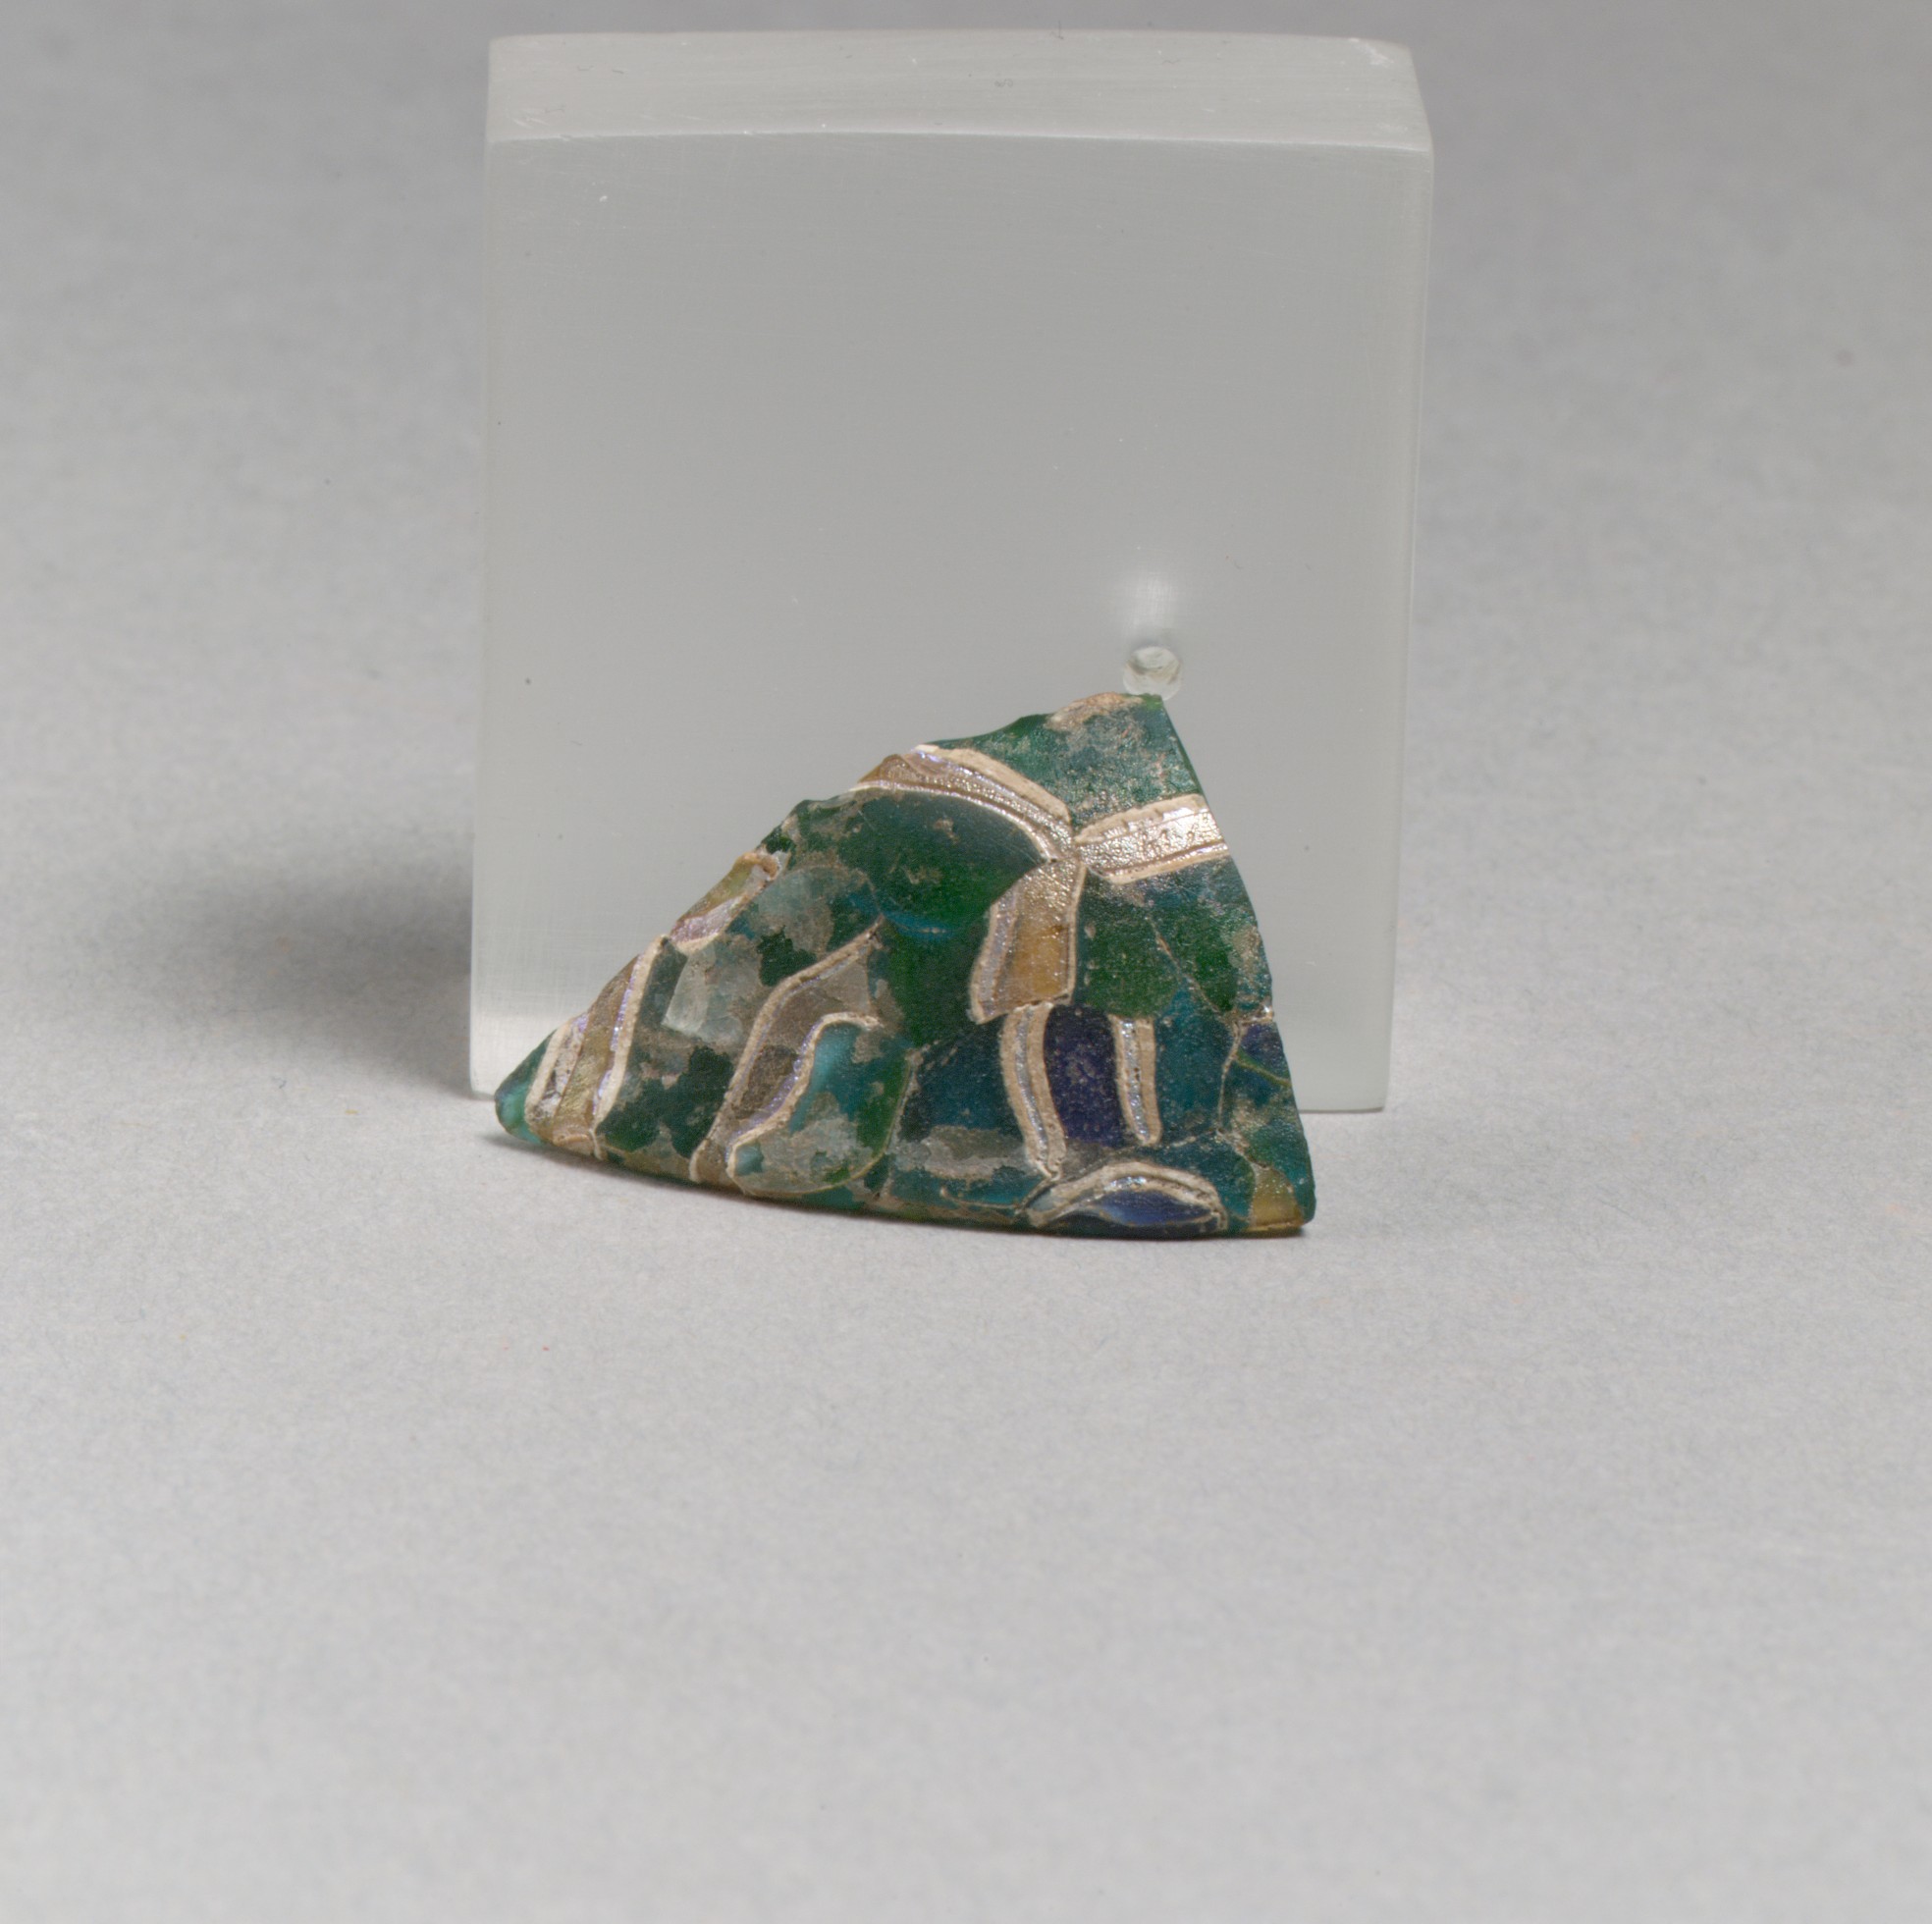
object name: fragment, mosaic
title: Glass mosaic fragment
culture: roman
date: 34 BCE-33 CE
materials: glass